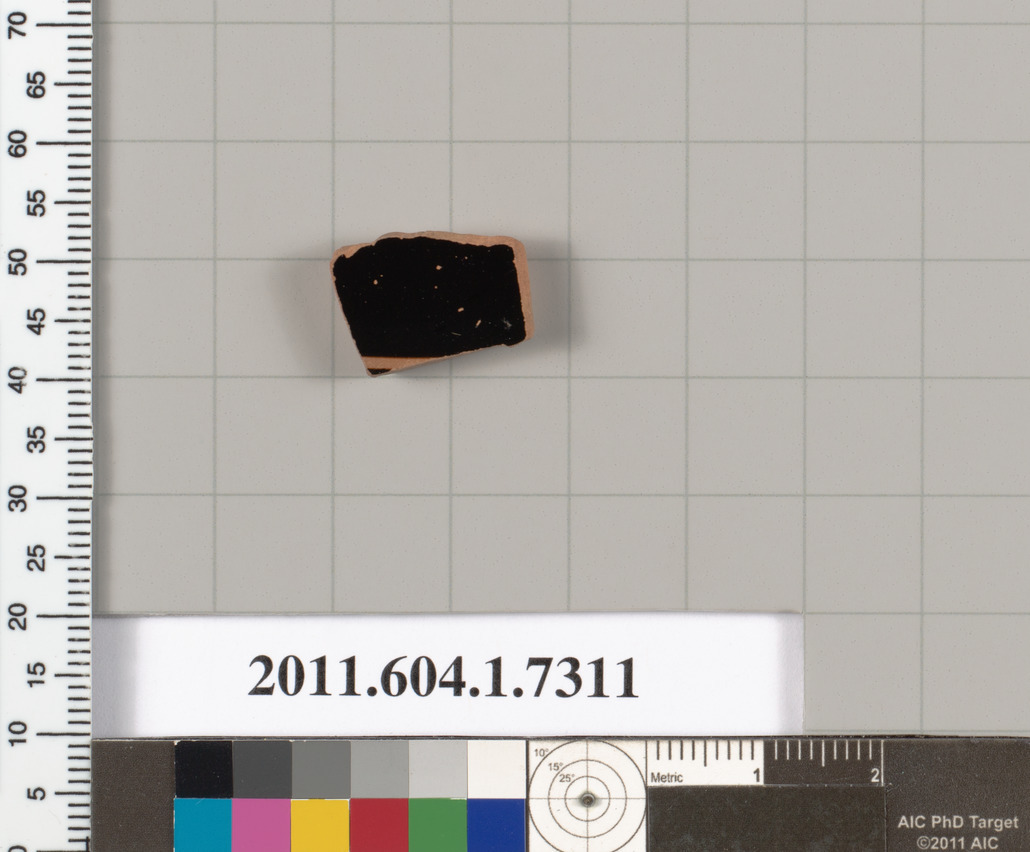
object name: kylix fragment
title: Terracotta fragment of a kylix (drinking cup)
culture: greek, attic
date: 500-480 BCE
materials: terracotta